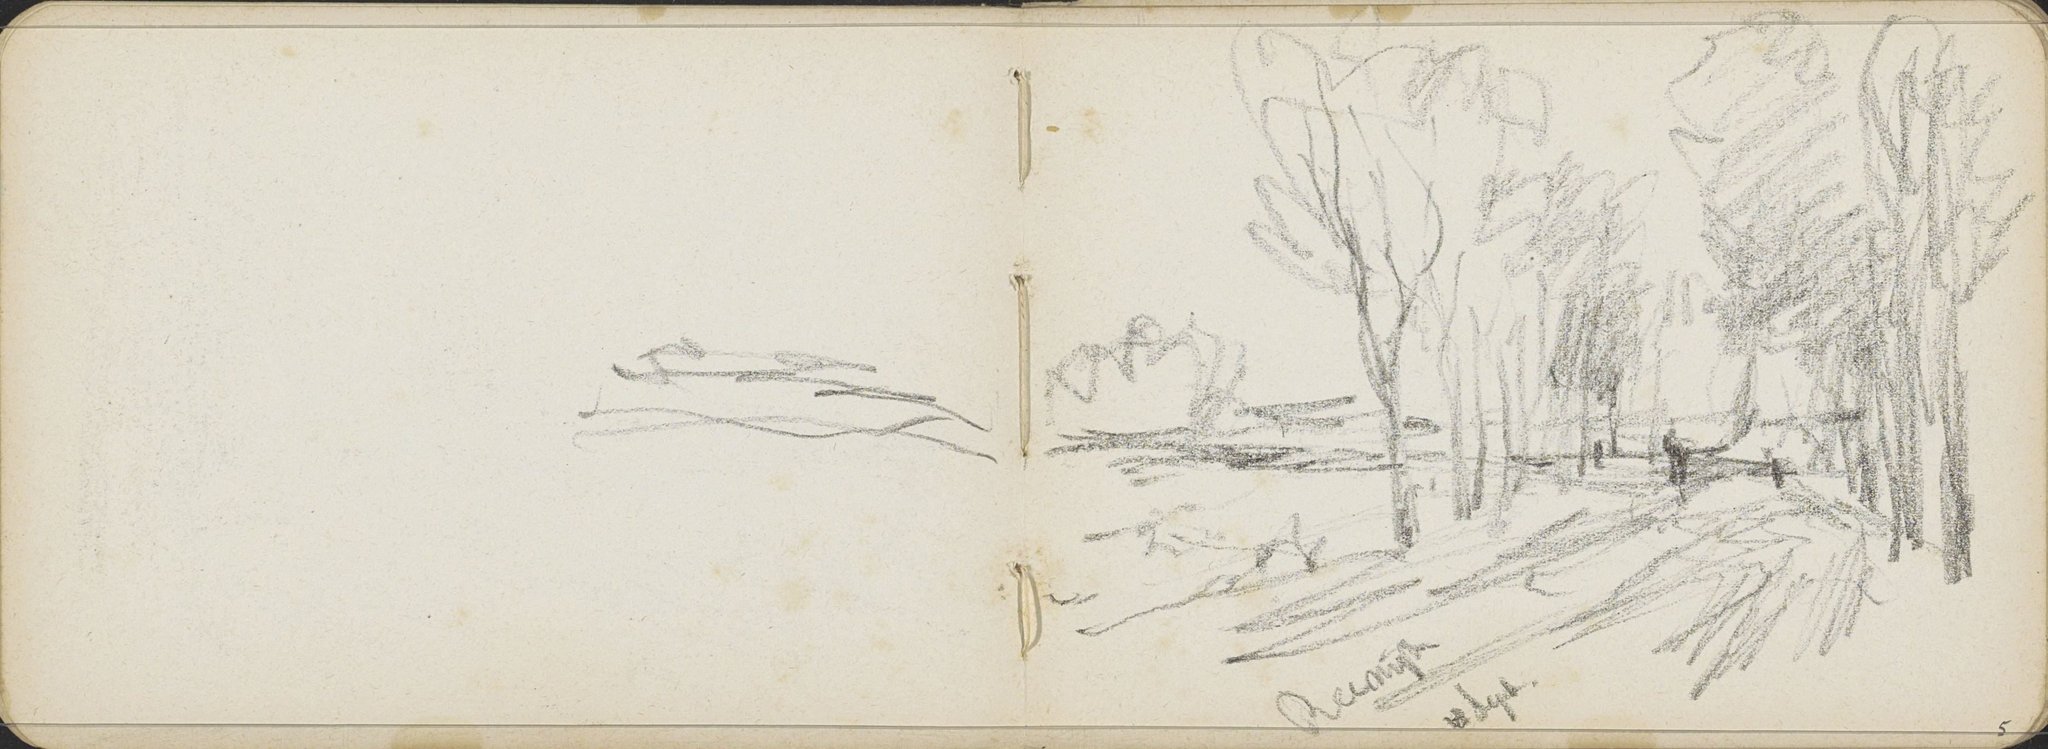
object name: sketchbook leaf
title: Figuren op een bomenlaan te Reeuwijk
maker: willem cornelis rip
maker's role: draughtsman, painter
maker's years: 1856-1922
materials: chalk, paper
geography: reeuwijk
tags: road, path, landscapes (+ landscape with figures, staffage)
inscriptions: date and inscription: ‘Reeuwijk/ 18 Sept.’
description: Blad 4 verso en 5 recto uit een schetsboek met 44 bladen.